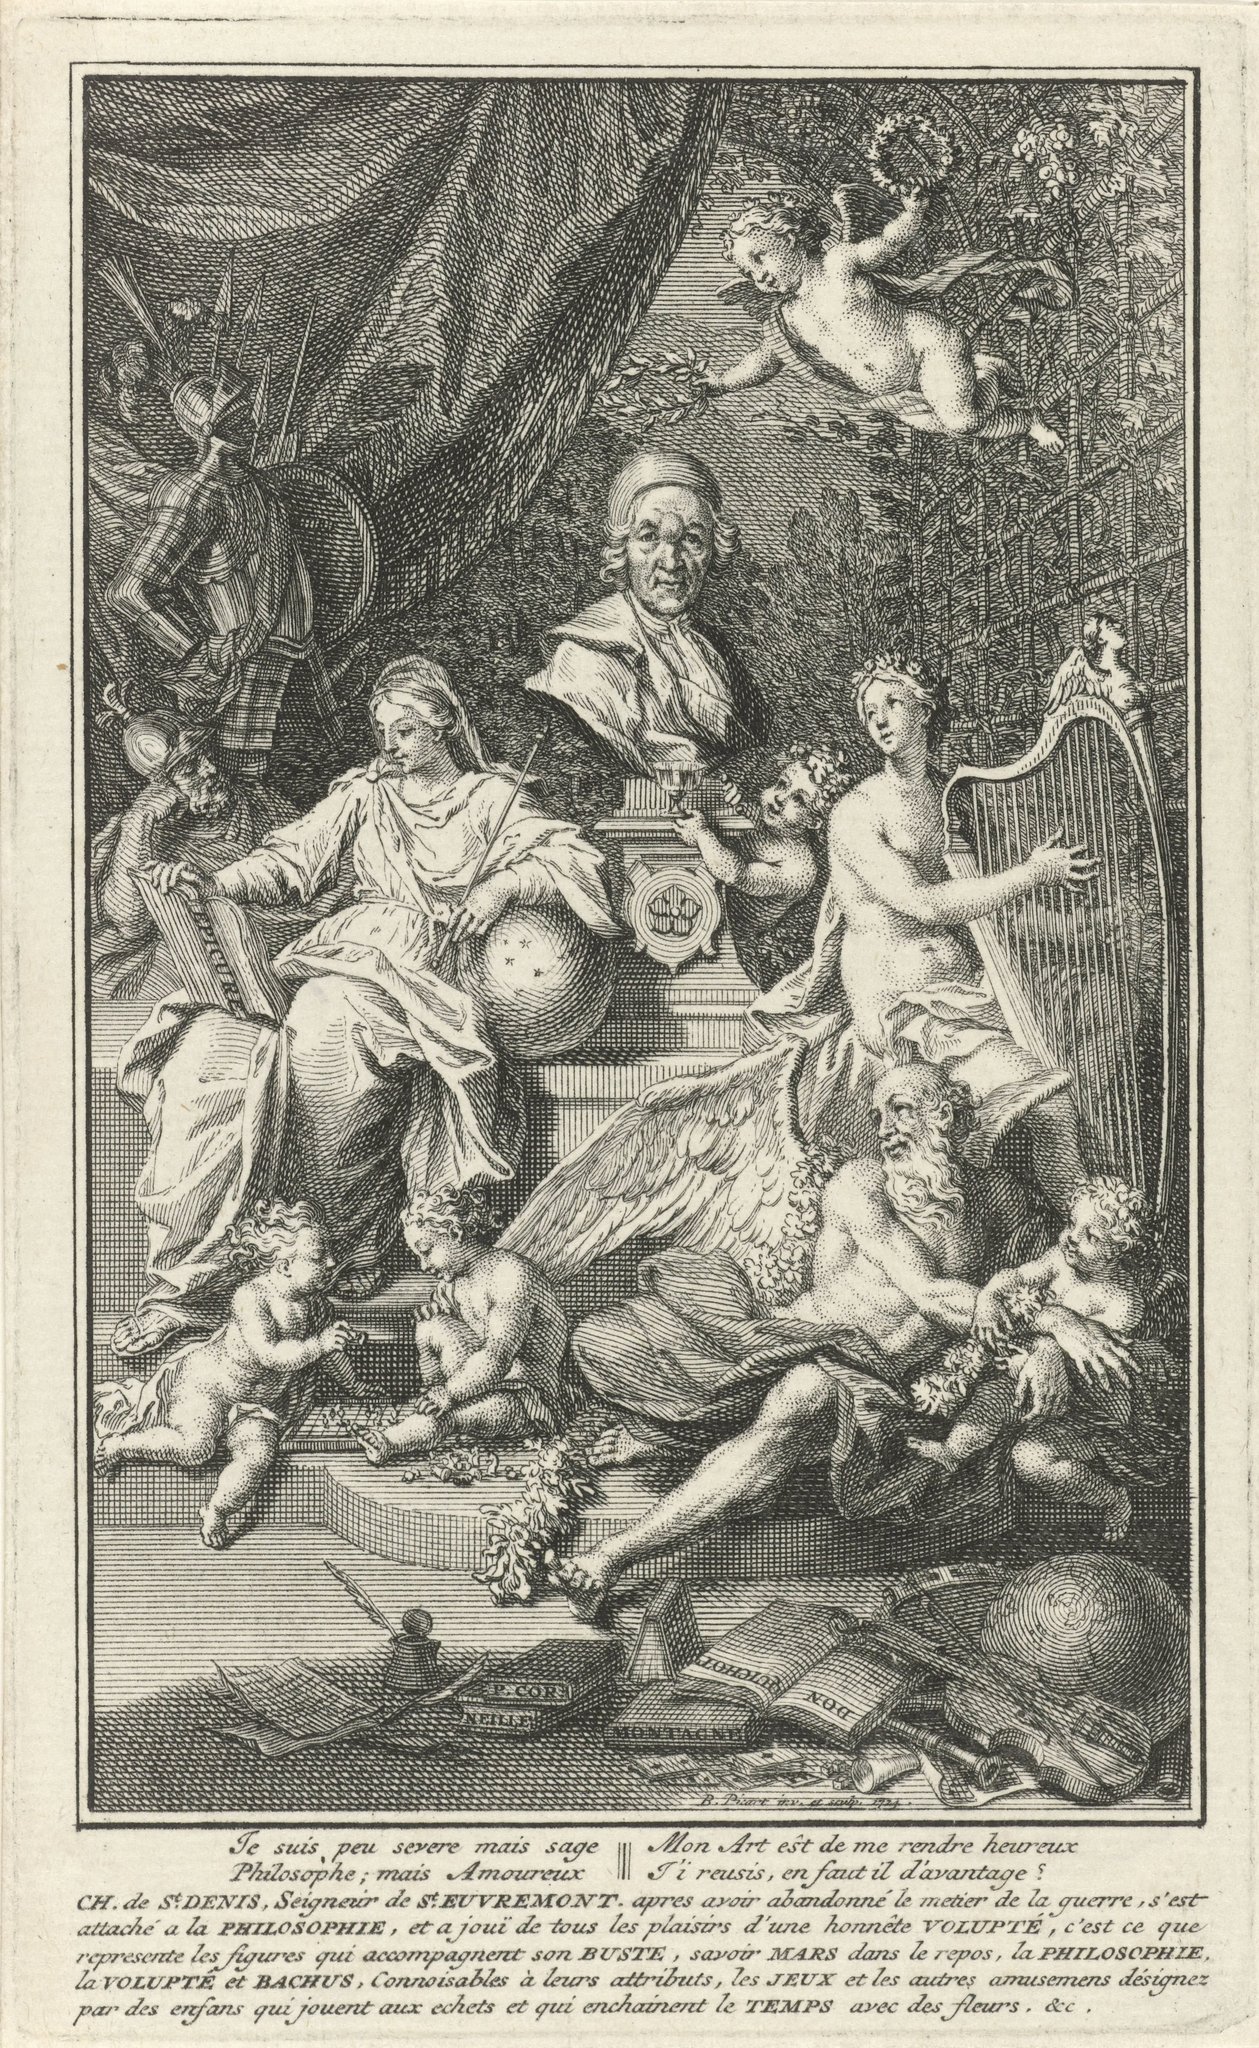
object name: print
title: Titelprent voor: Oeuvres de monsieur de Saint-Evremond, 1726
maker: bernard picart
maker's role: draughtsman, print maker, publisher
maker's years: 1673-1733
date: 1724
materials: paper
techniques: engraving, etching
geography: amsterdam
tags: (story of) mars (ares), voluptuousness, pleasure, 'voluptas' ~ one of the seven gifts of the body, chess, 'philosophia'; 'filosofia' (ripa), crowning with laurel, father time, man with wings and scythe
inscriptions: collector's mark: Lugt 240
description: Portretbuste van Charles de Saint Denis, heer van Saint Évremond, door een putto gelauwerd. De buste is omringd door Mars (hij slaapt als verwijzing naar het einde van de militaire loopbaan van de geportretteerde), Filosofie (met scepter en globe), Wellust (met harp) en Vader Tijd. Op de voorgrond zijn twee putti aan het schaken. In de marge een vierregelig gedicht en een vijfregelig onderschrift in het Frans.